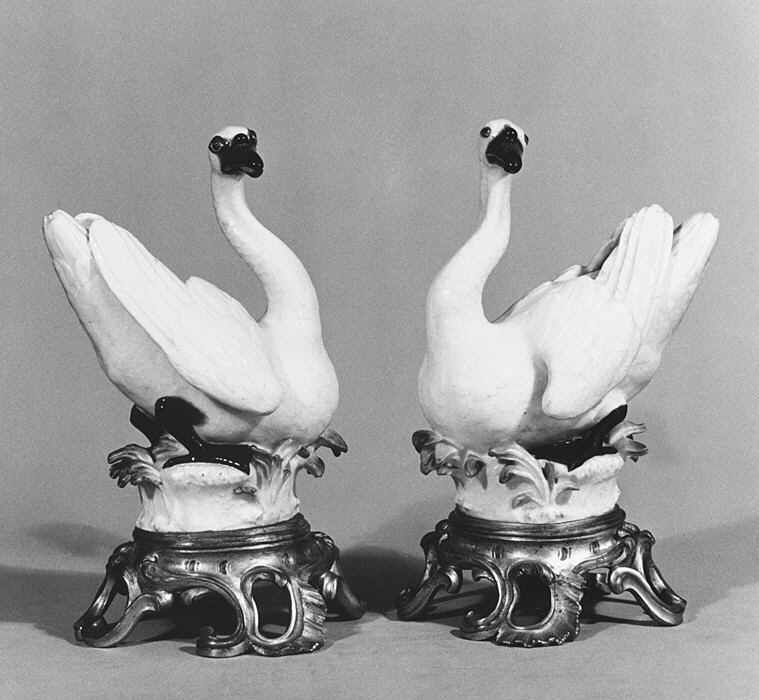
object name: figure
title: Swan (one of a pair)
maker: meissen manufactory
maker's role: manufactory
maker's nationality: german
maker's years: 1710-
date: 1748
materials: hard paste porcelain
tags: swans